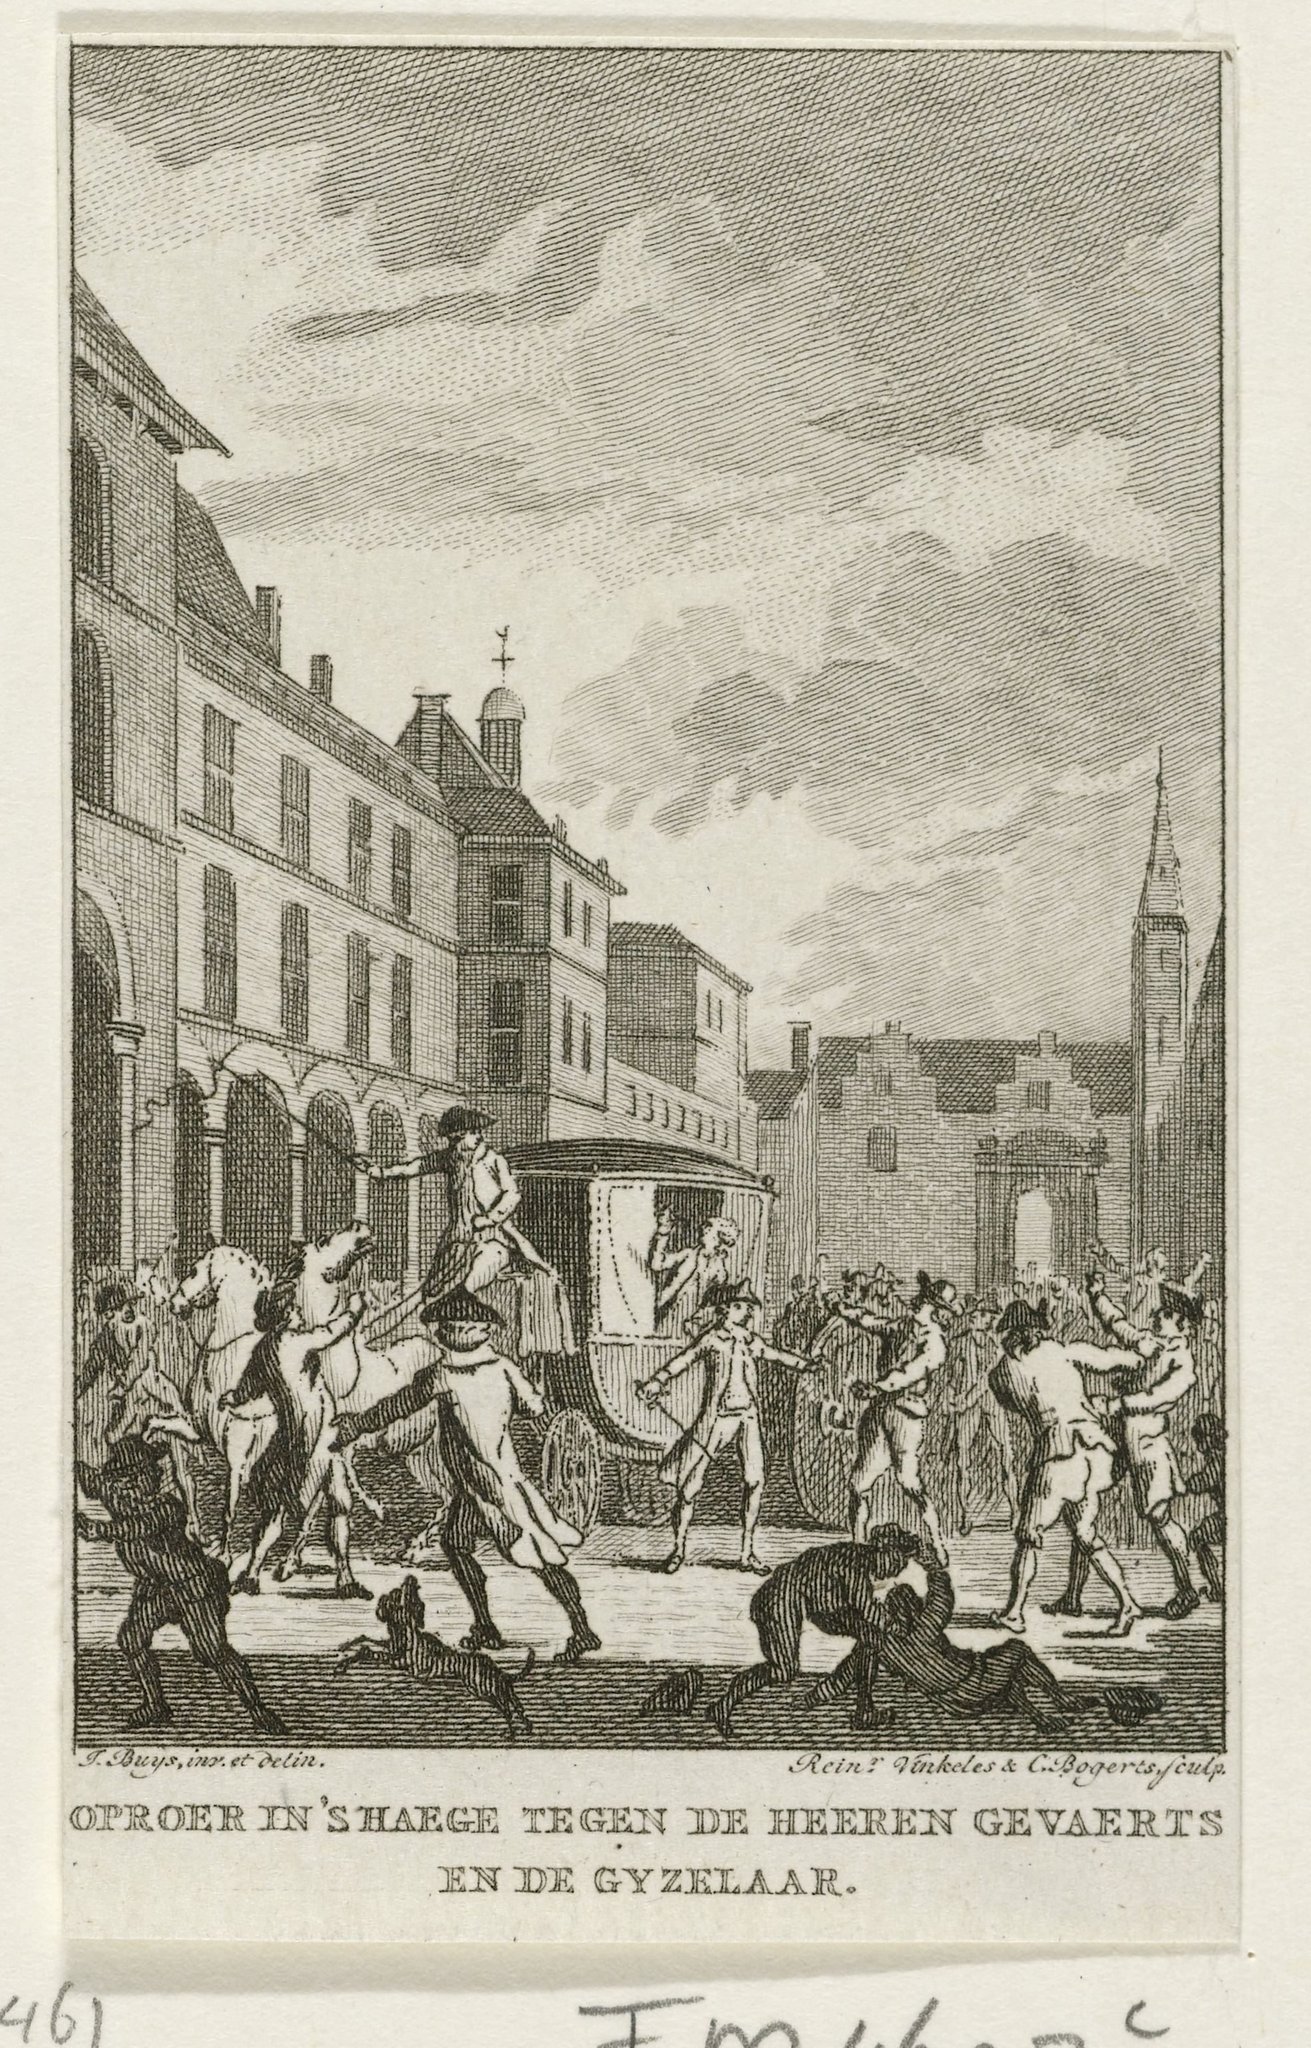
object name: print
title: Oproer in 's Hage tegen de heeren Gevaerts en De Gyzelaar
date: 1786-1795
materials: paper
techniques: engraving, etching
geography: northern netherlands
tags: revolutionary action (violent)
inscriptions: collector's mark: Lugt 2228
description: Aanslag door de Haagse pruikenmaker F. Mourand op het rijtuig van de gedeputeerden van Dordrecht, de heren Gevaerts en De Gijzelaar, als zij door de Stadhouderspoort het Binnenhof op willen rijden, 17 maart 1786.